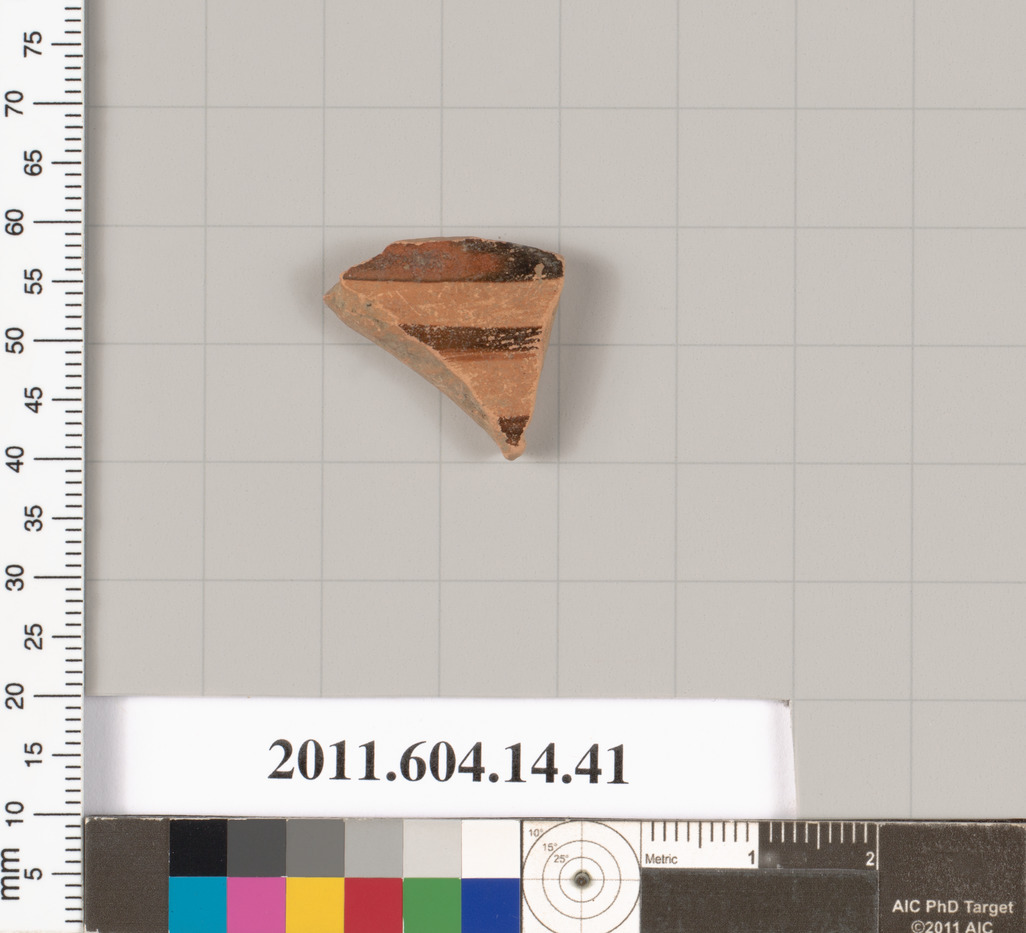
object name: undetermined closed shape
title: Terracotta fragment of a closed shape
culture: unknown fabric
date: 600-401 BCE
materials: terracotta